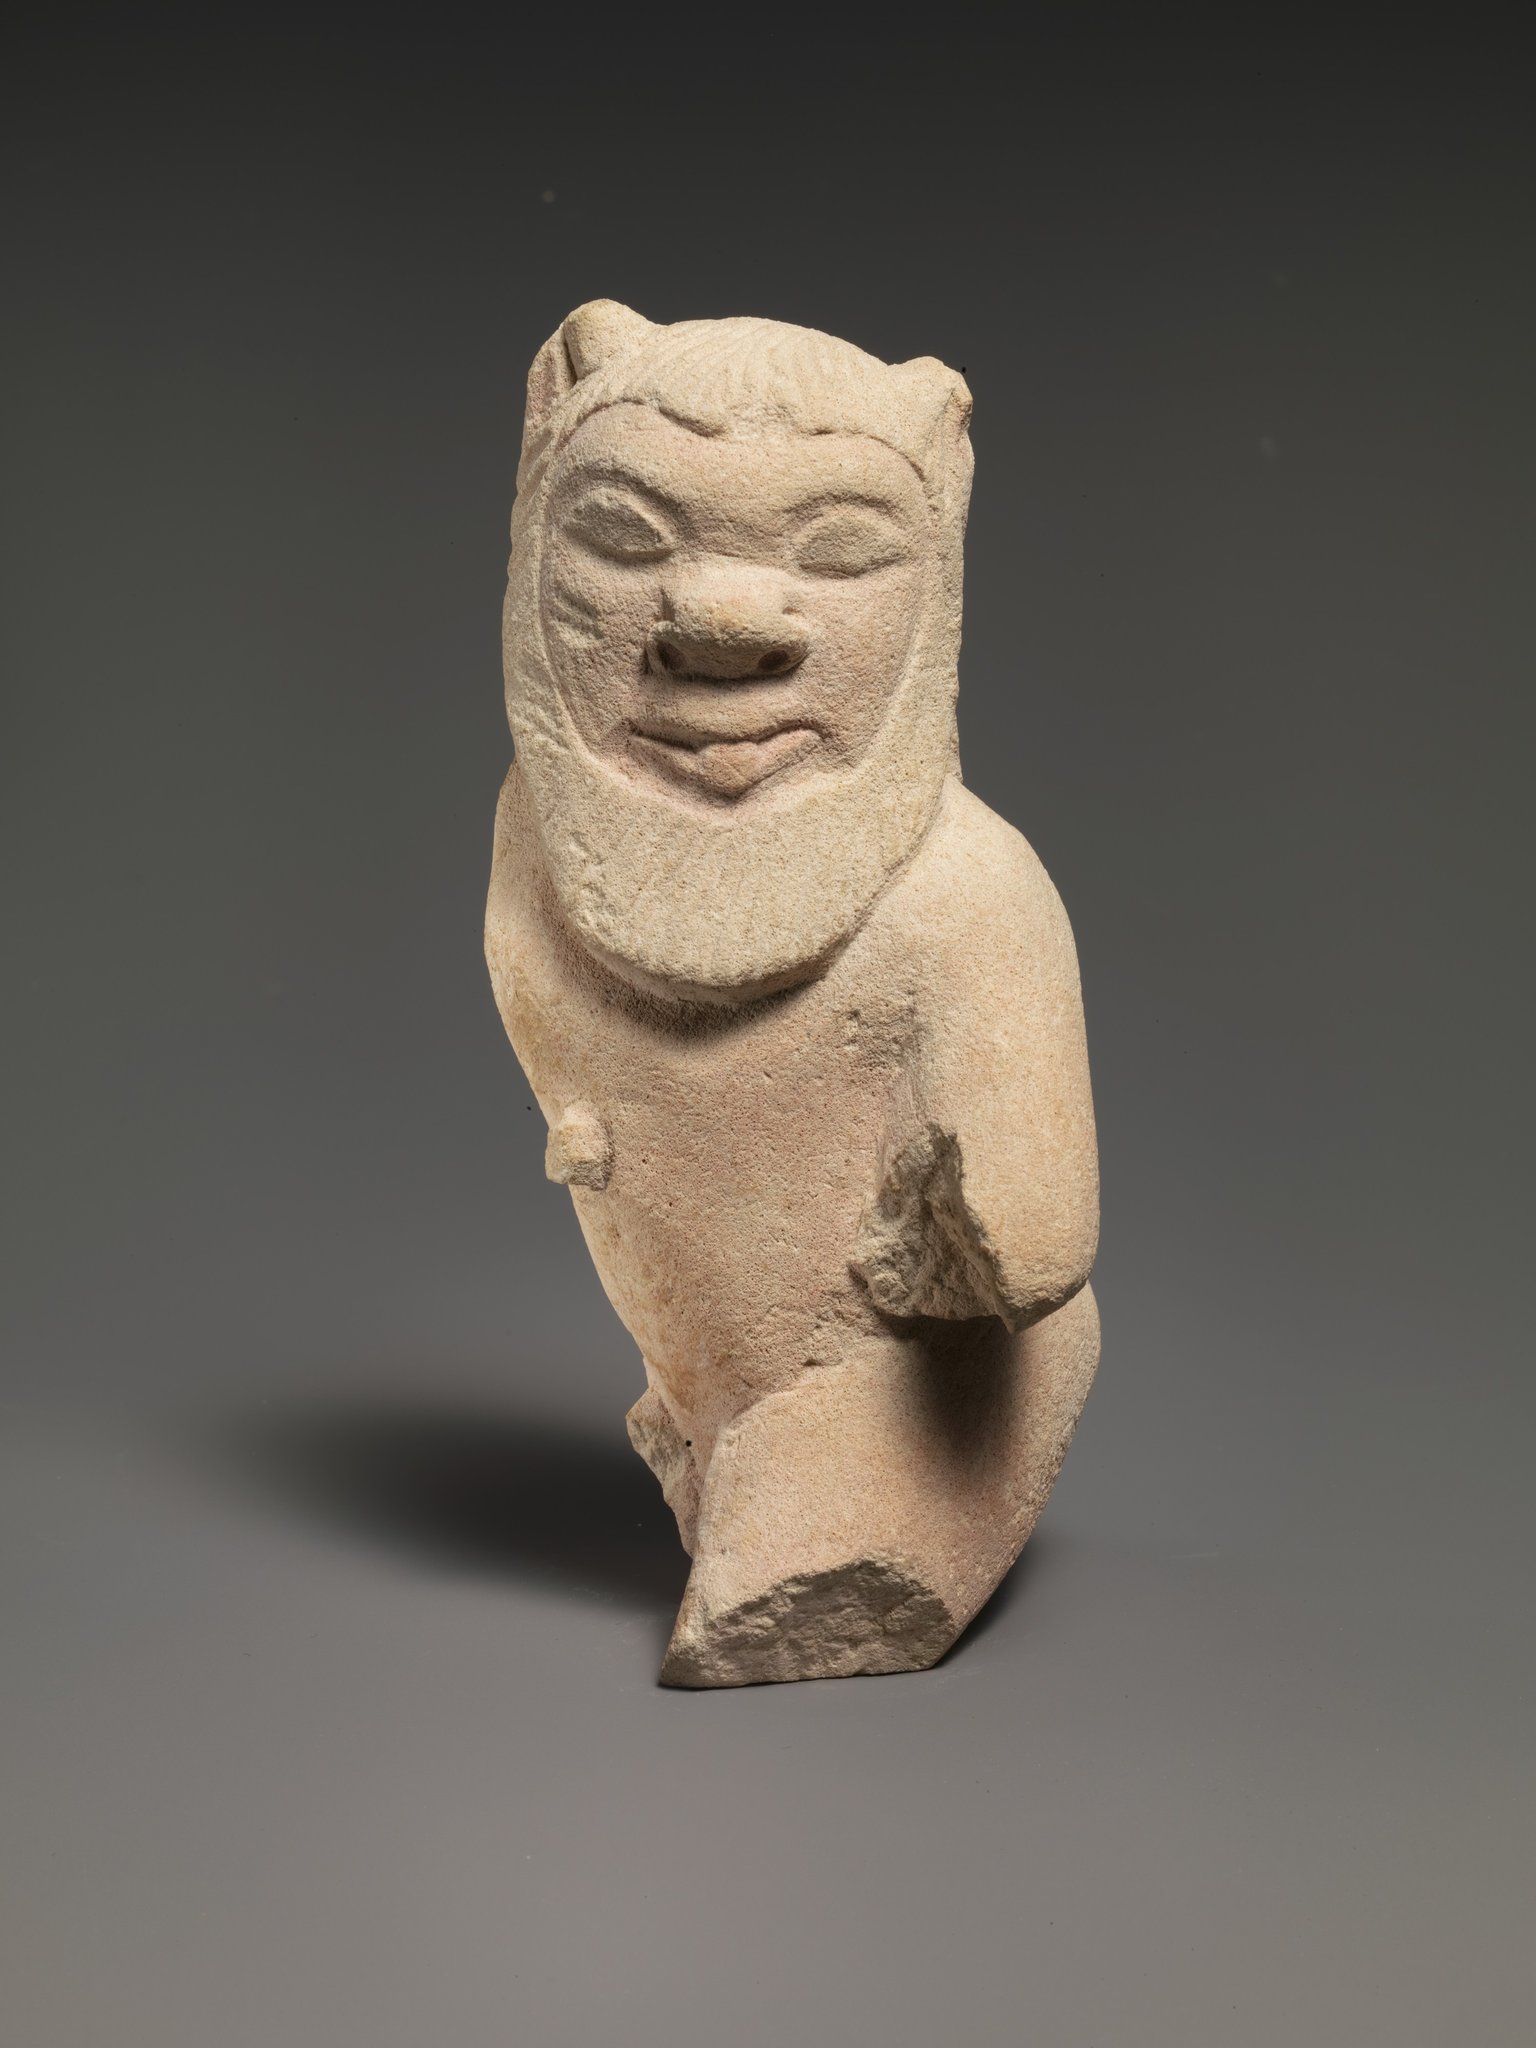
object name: statuette of be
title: Limestone Bes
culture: cypriot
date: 534-468 BCE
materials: limestone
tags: bes